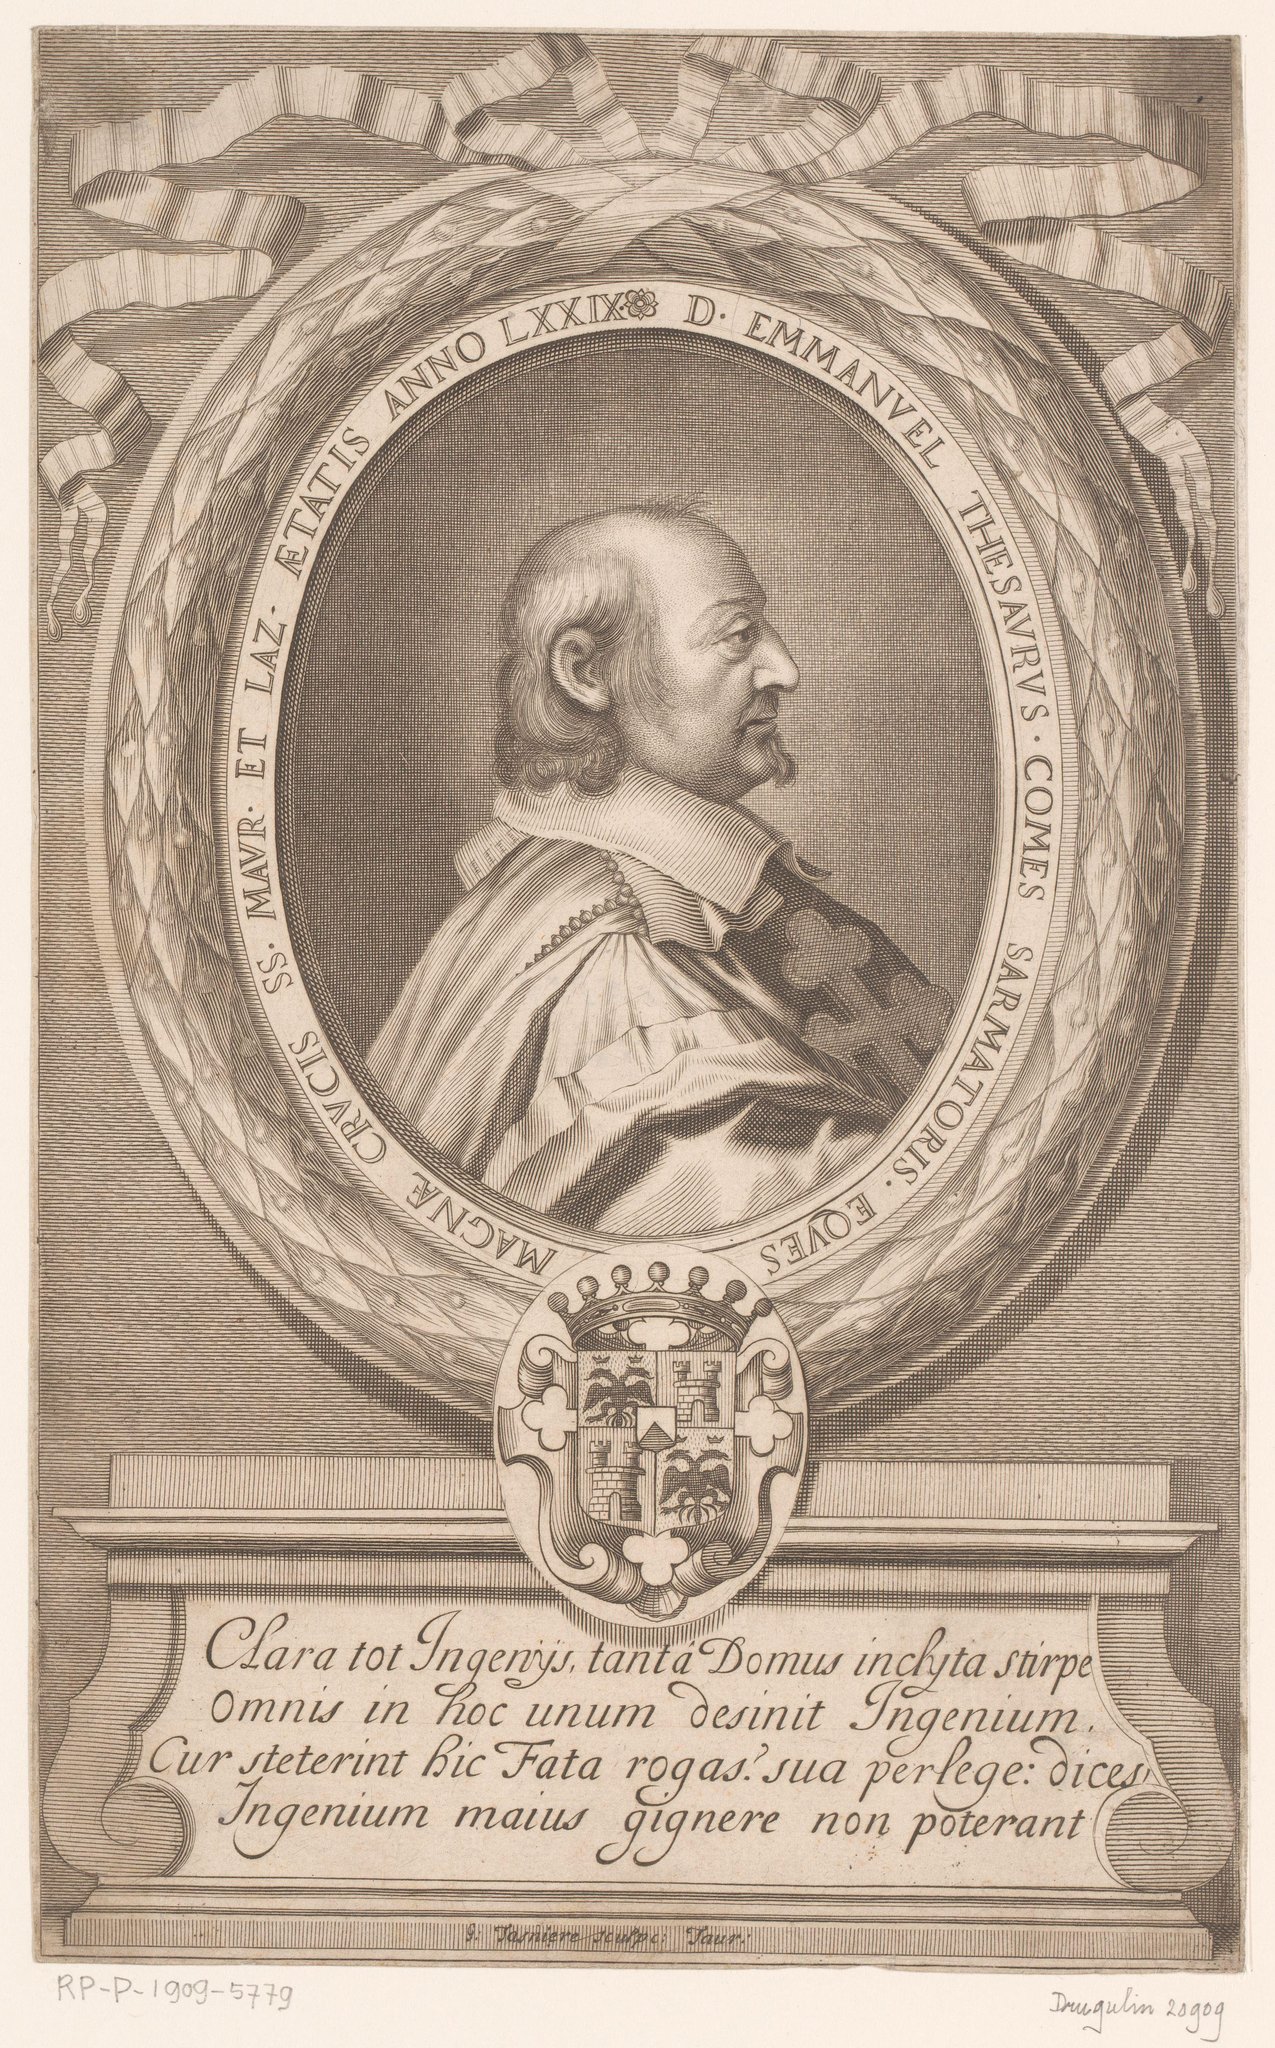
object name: print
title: Portret van Emanuel Thesaurus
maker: georges tasnière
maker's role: print maker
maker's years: 1632-1704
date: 1642-1704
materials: paper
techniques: engraving, etching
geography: turin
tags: historical persons, historical persons (portraits and scenes from the life) (+ half-length portrait)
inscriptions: collector's mark: Lugt 2228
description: Portret van de letterkundige op 79-jarige leeftijd. Onder zijn beeltenis een wapenschild en een banderol met lofuitingen op hem en zijn familie.